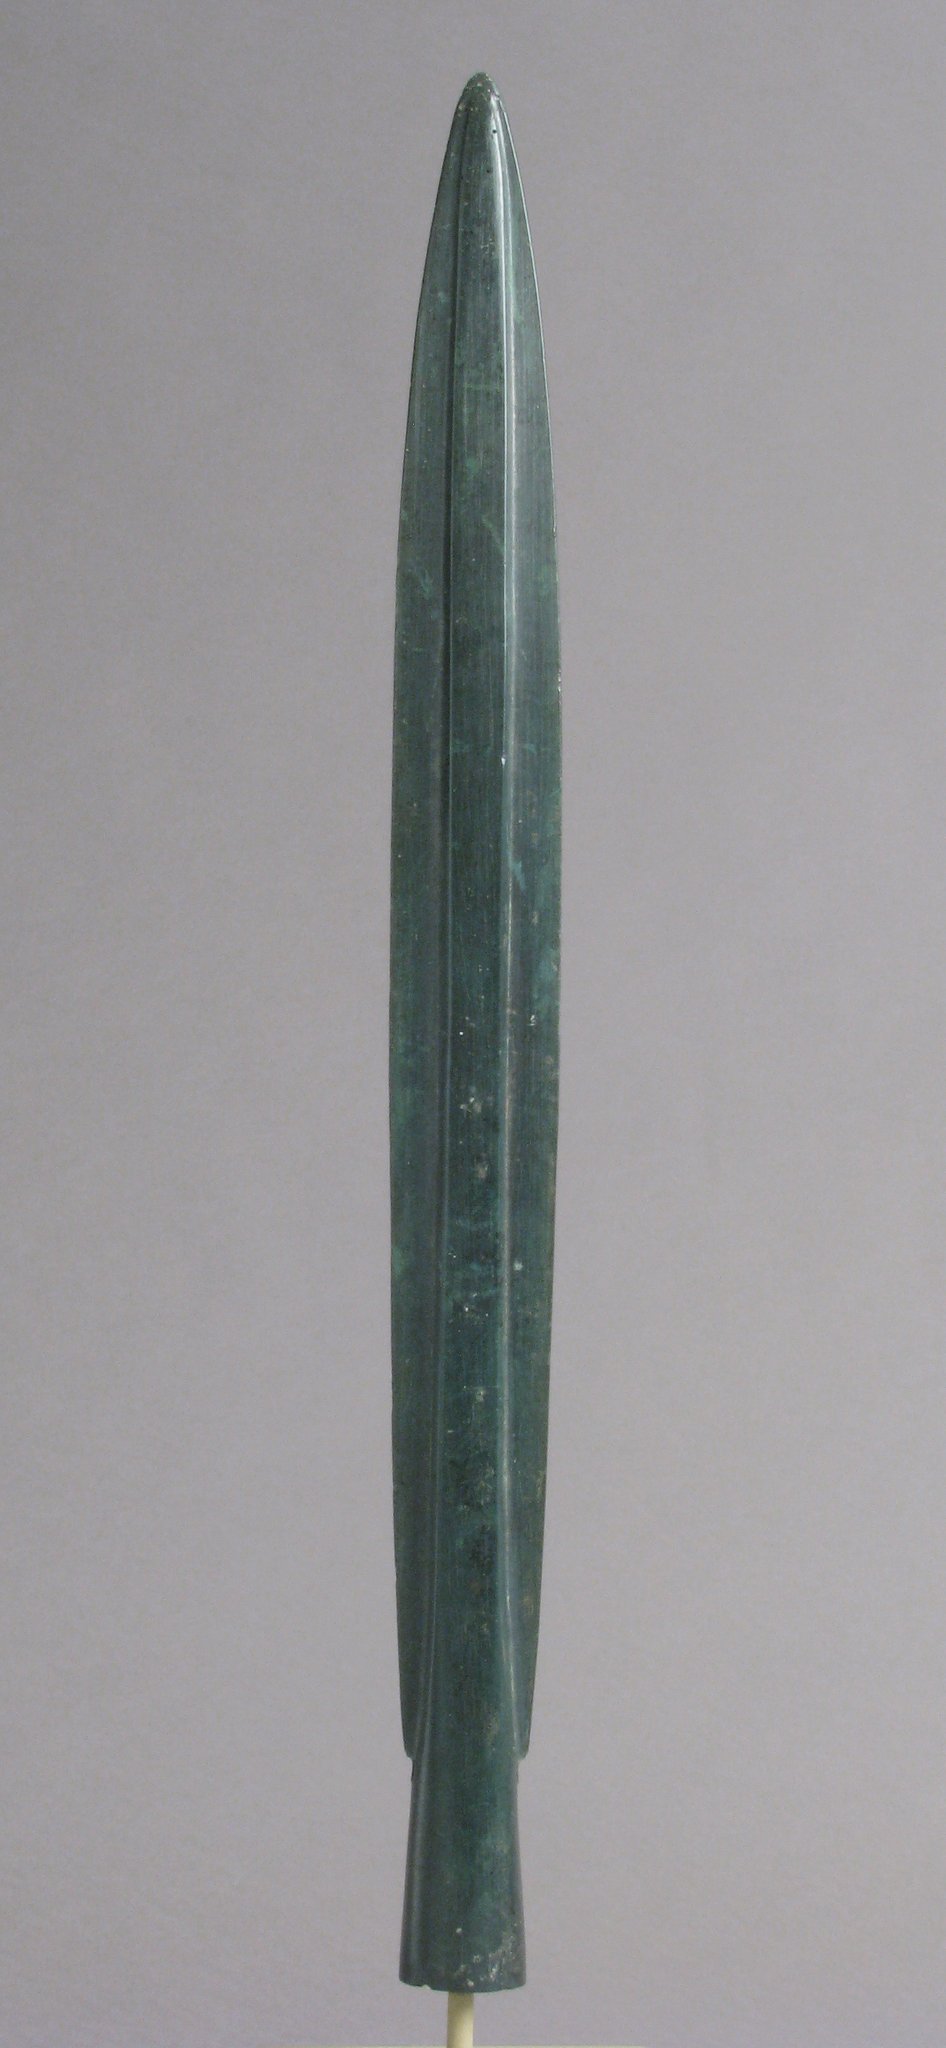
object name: spearhead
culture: bronze age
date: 1200-900 BCE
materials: copper alloy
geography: carpathian basin